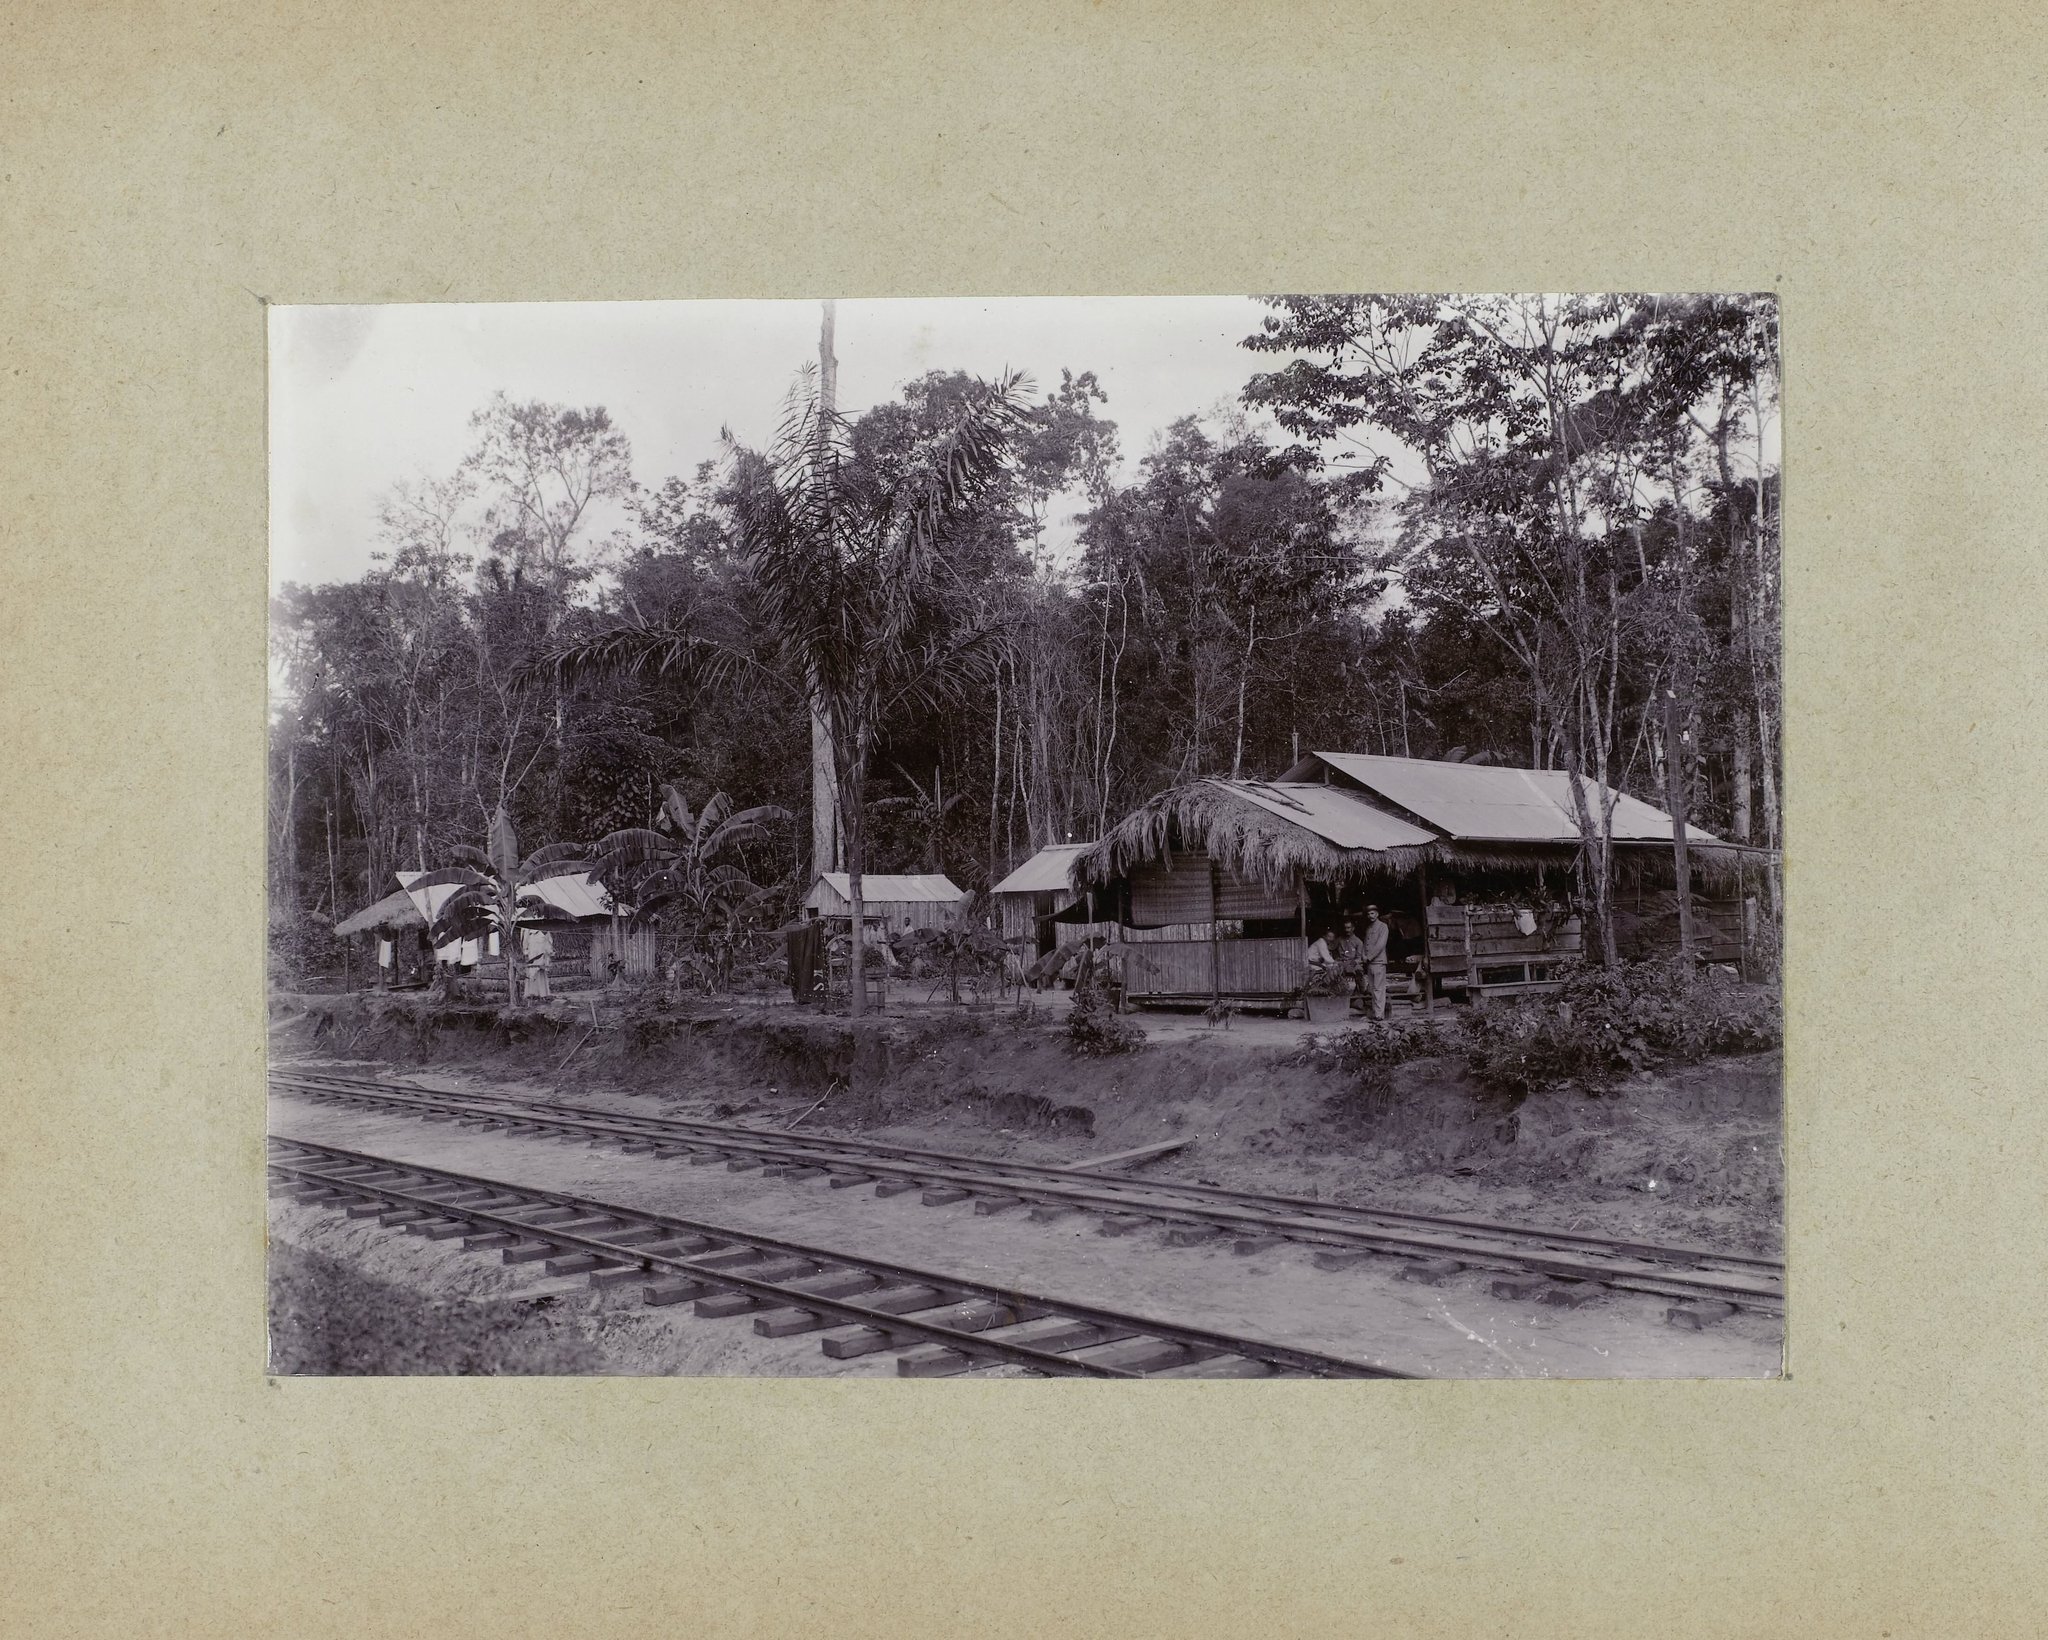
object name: photograph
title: Kamp langs Lawaspoorlijn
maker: augusta curiel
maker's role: fotograaf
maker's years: 1873-1937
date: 1905-1910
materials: photographic support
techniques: photography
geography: suriname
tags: jacob evert wesenhagen, railway, tramway; rack railway, suriname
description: Gezicht op de kamp langs Lawaspoorlijn. Foto in het fotoalbum over de aanleg van de Lawaspoorweg in Suriname in de jaren 1903-1912. Onderdeel van een groep objecten afkomstig van de familie Wesenhagen in Suriname.